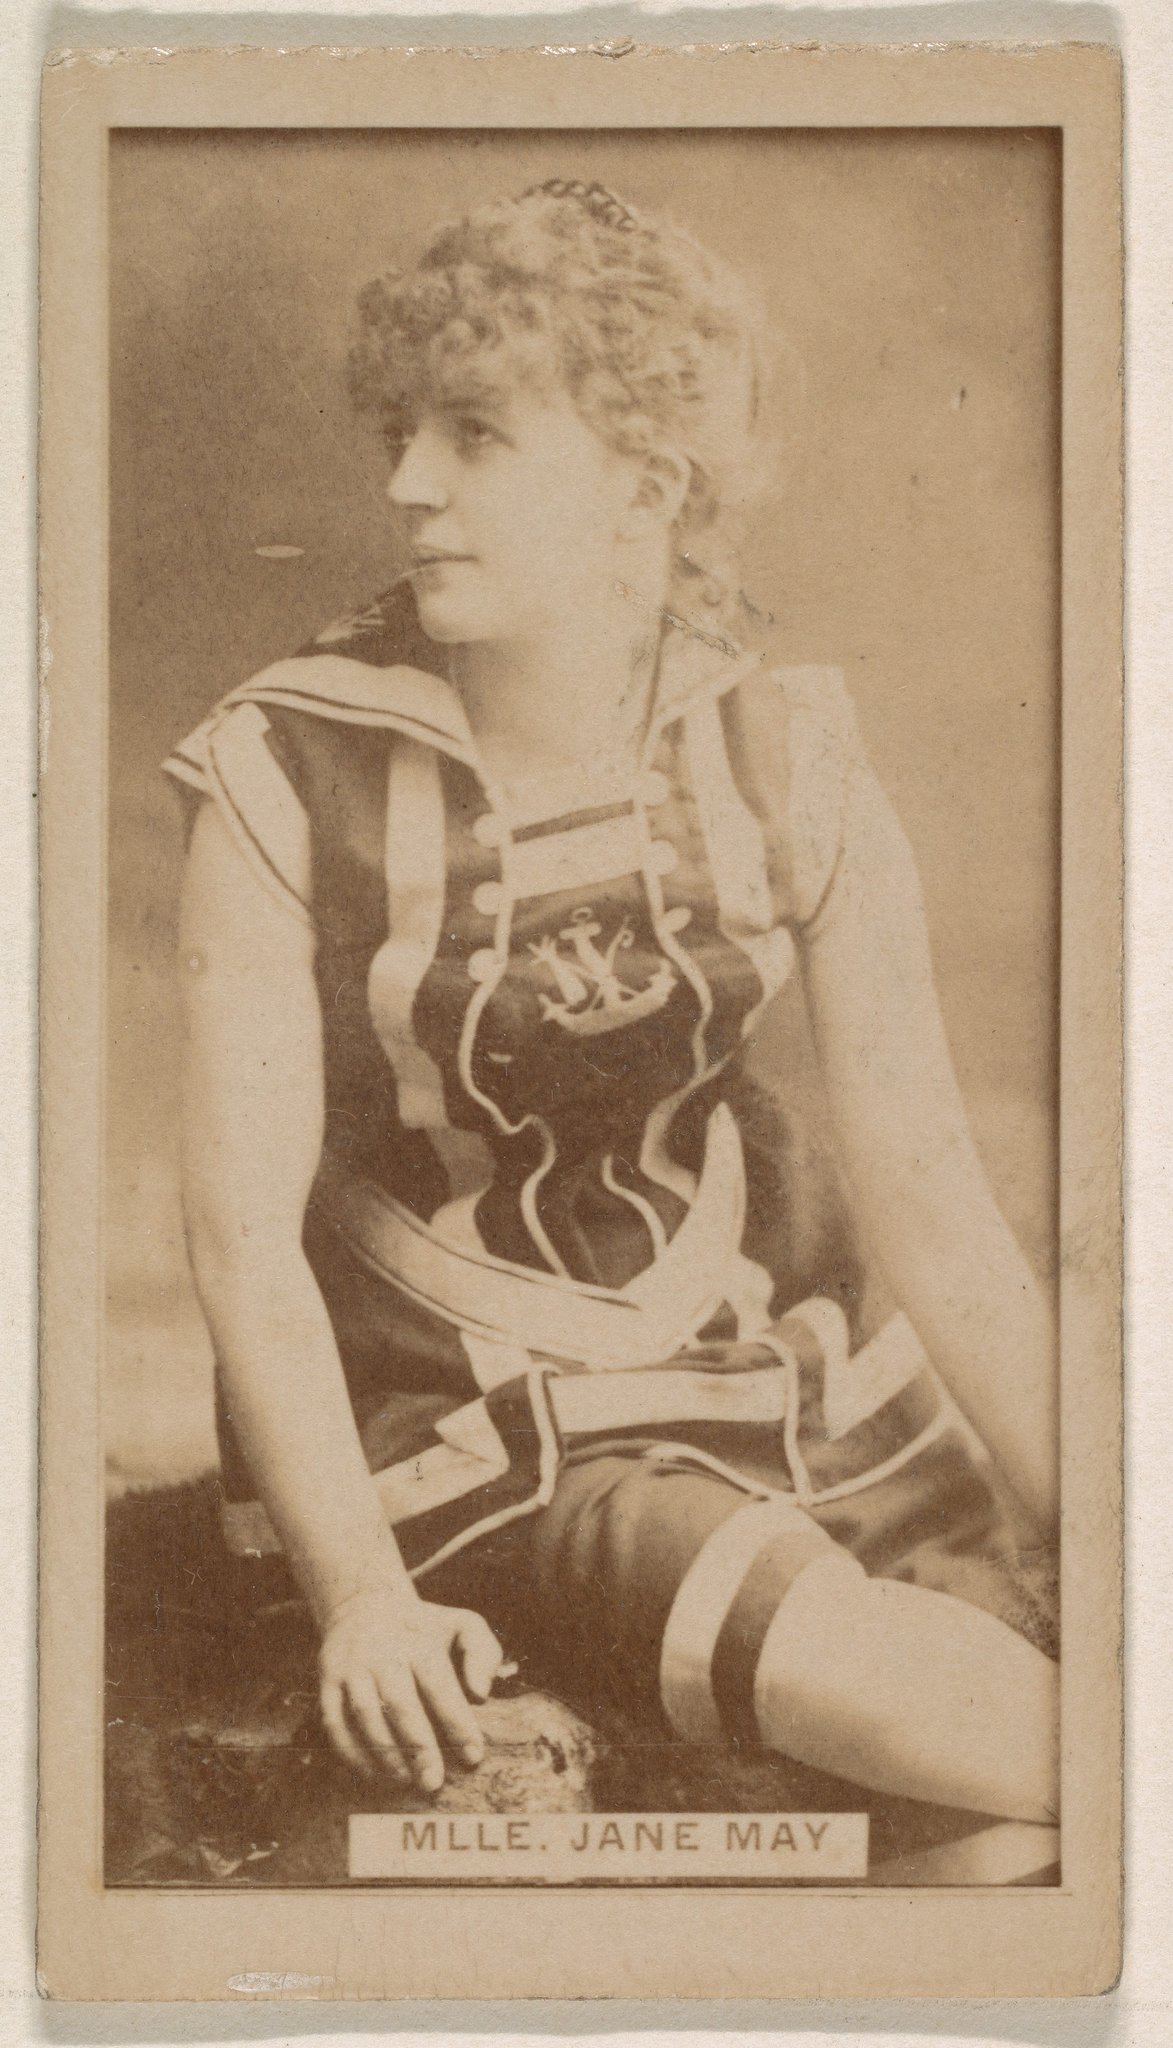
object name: photograph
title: Mlle. Jane May, from the Actresses series (N245) issued by Kinney Brothers to promote Sweet Caporal Cigarettes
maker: kinney brothers tobacco company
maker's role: publisher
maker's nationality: american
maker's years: 1869-2011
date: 1890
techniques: albumen silver print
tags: portraits,women,actresses